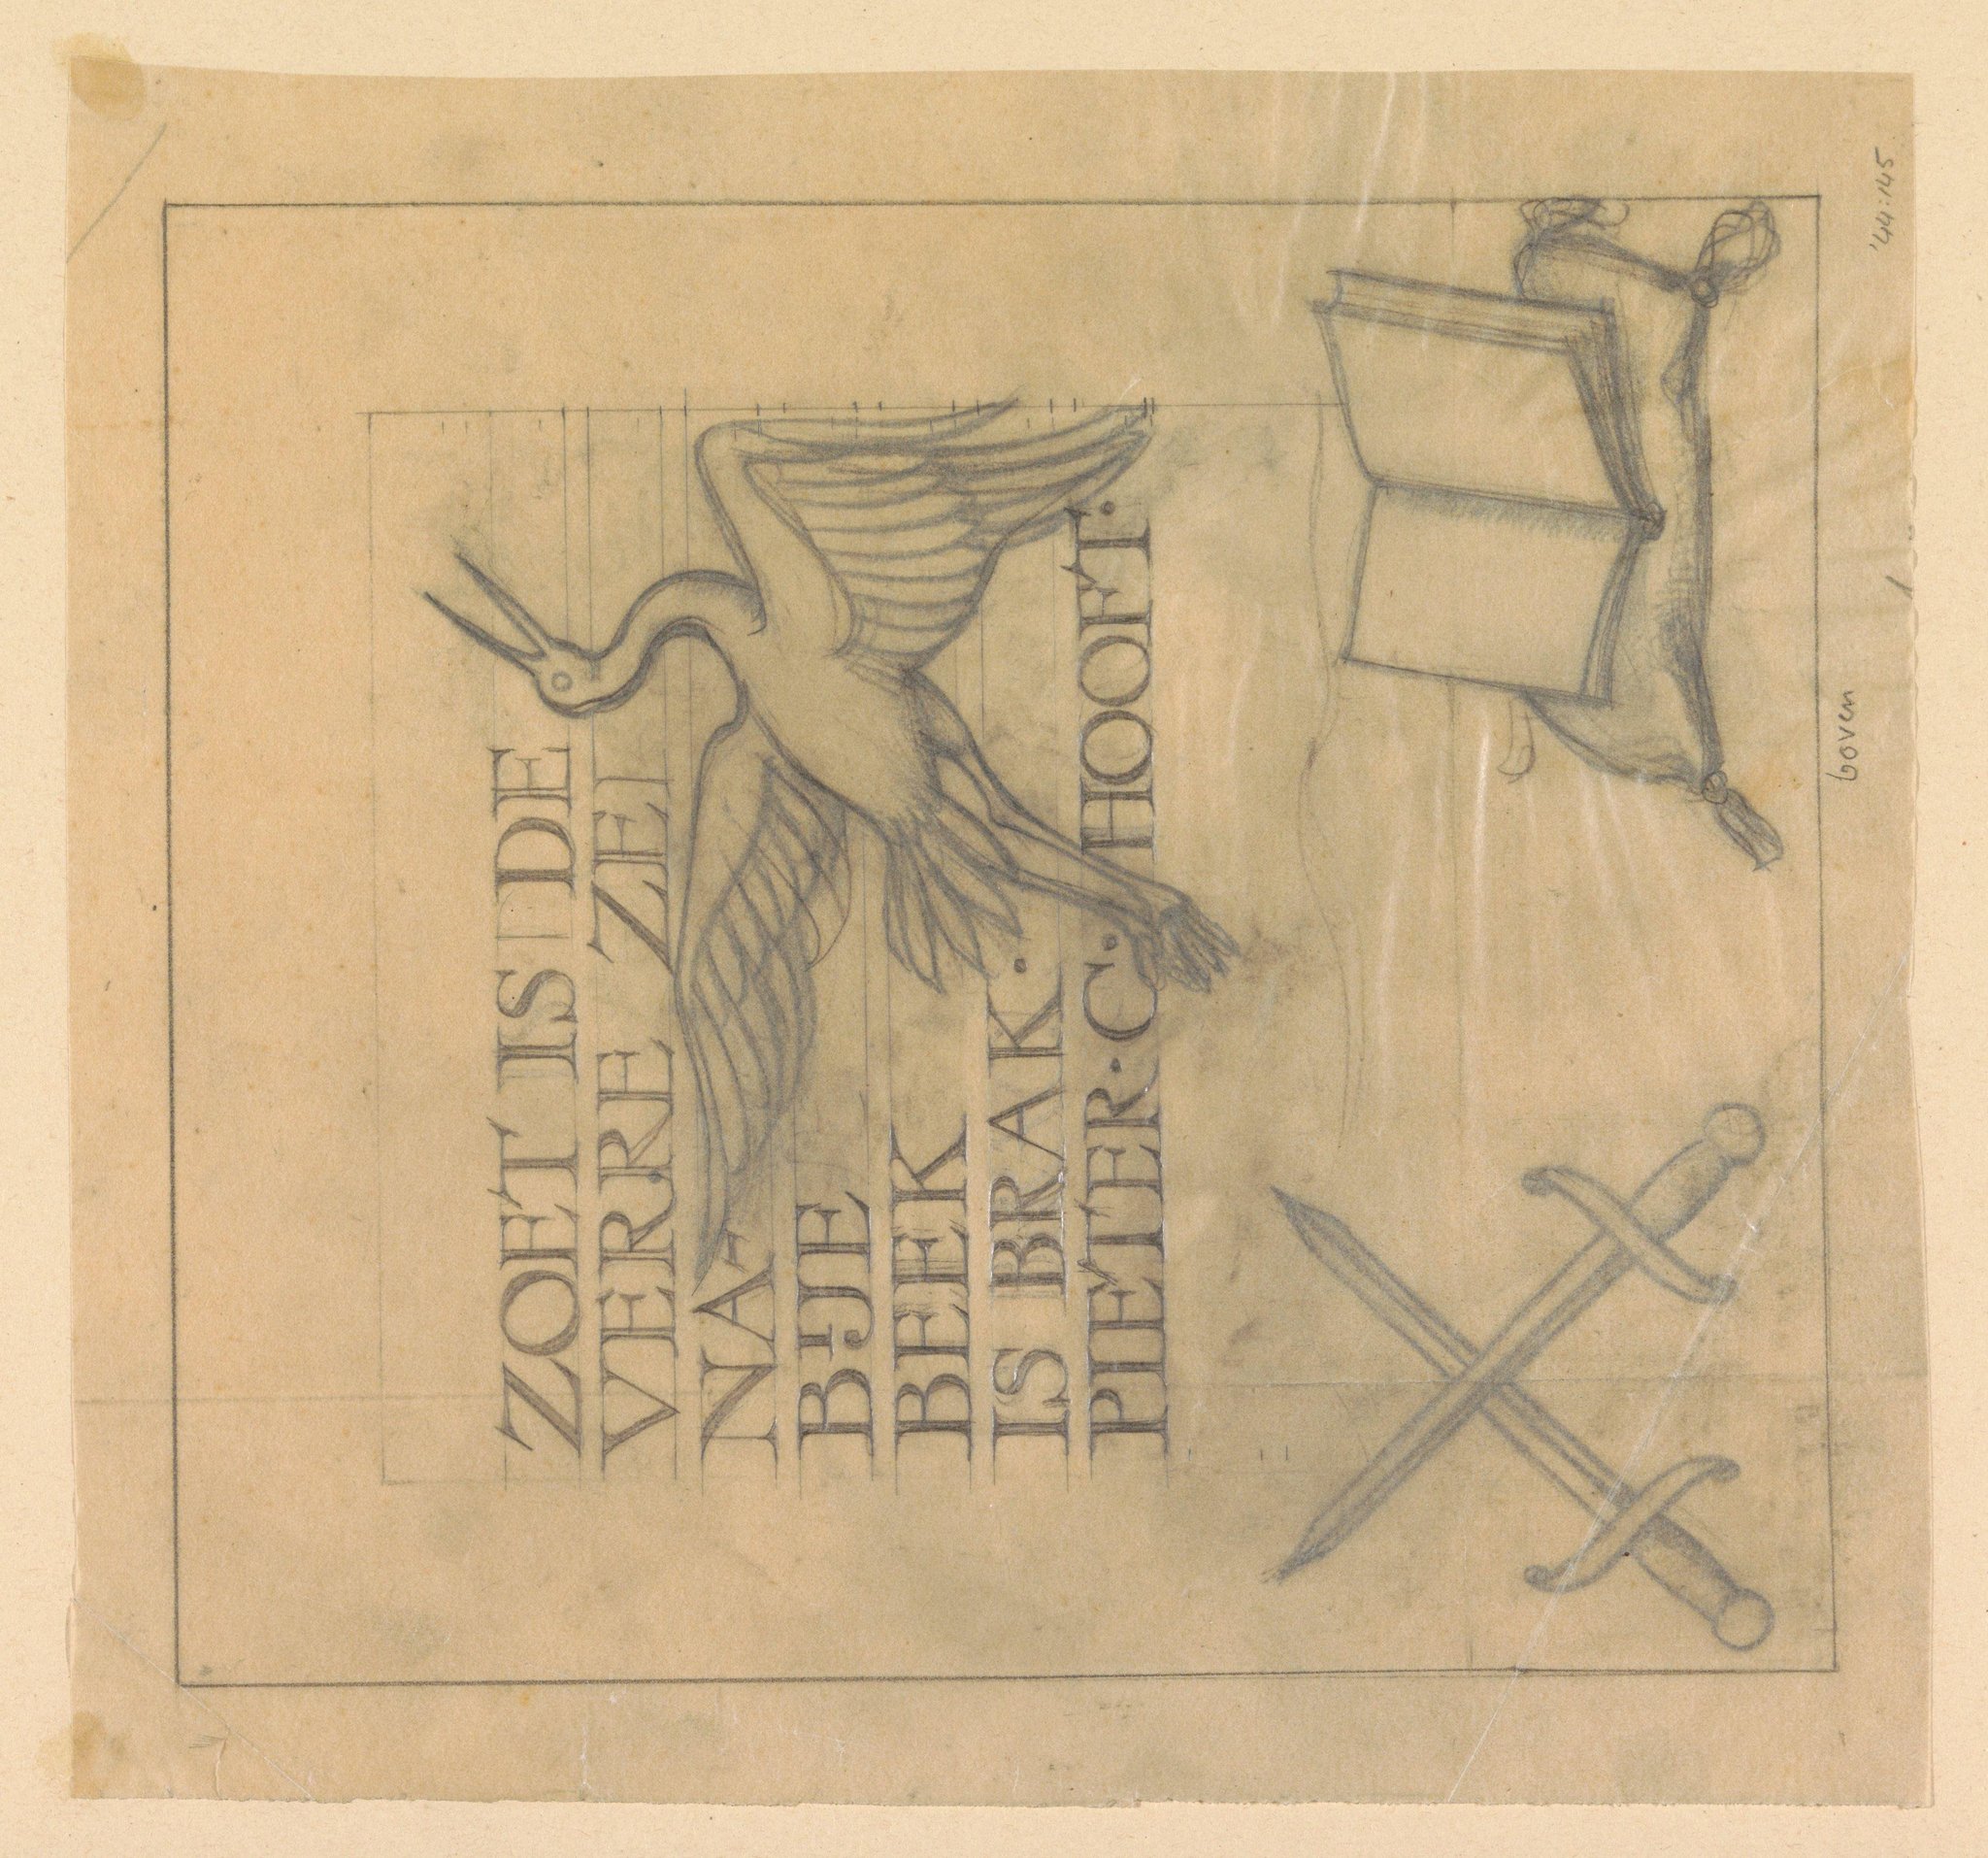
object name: tracing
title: Ontwerp voor wandschildering in de Beurs van Berlage: embleem met spreuk van P. C. Hooft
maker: antoon derkinderen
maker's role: draughtsman, painter, print maker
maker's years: 1859-1925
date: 1869-1925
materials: pencil, paper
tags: the hague, pieter corneliszoon hooft, inscription, historical persons